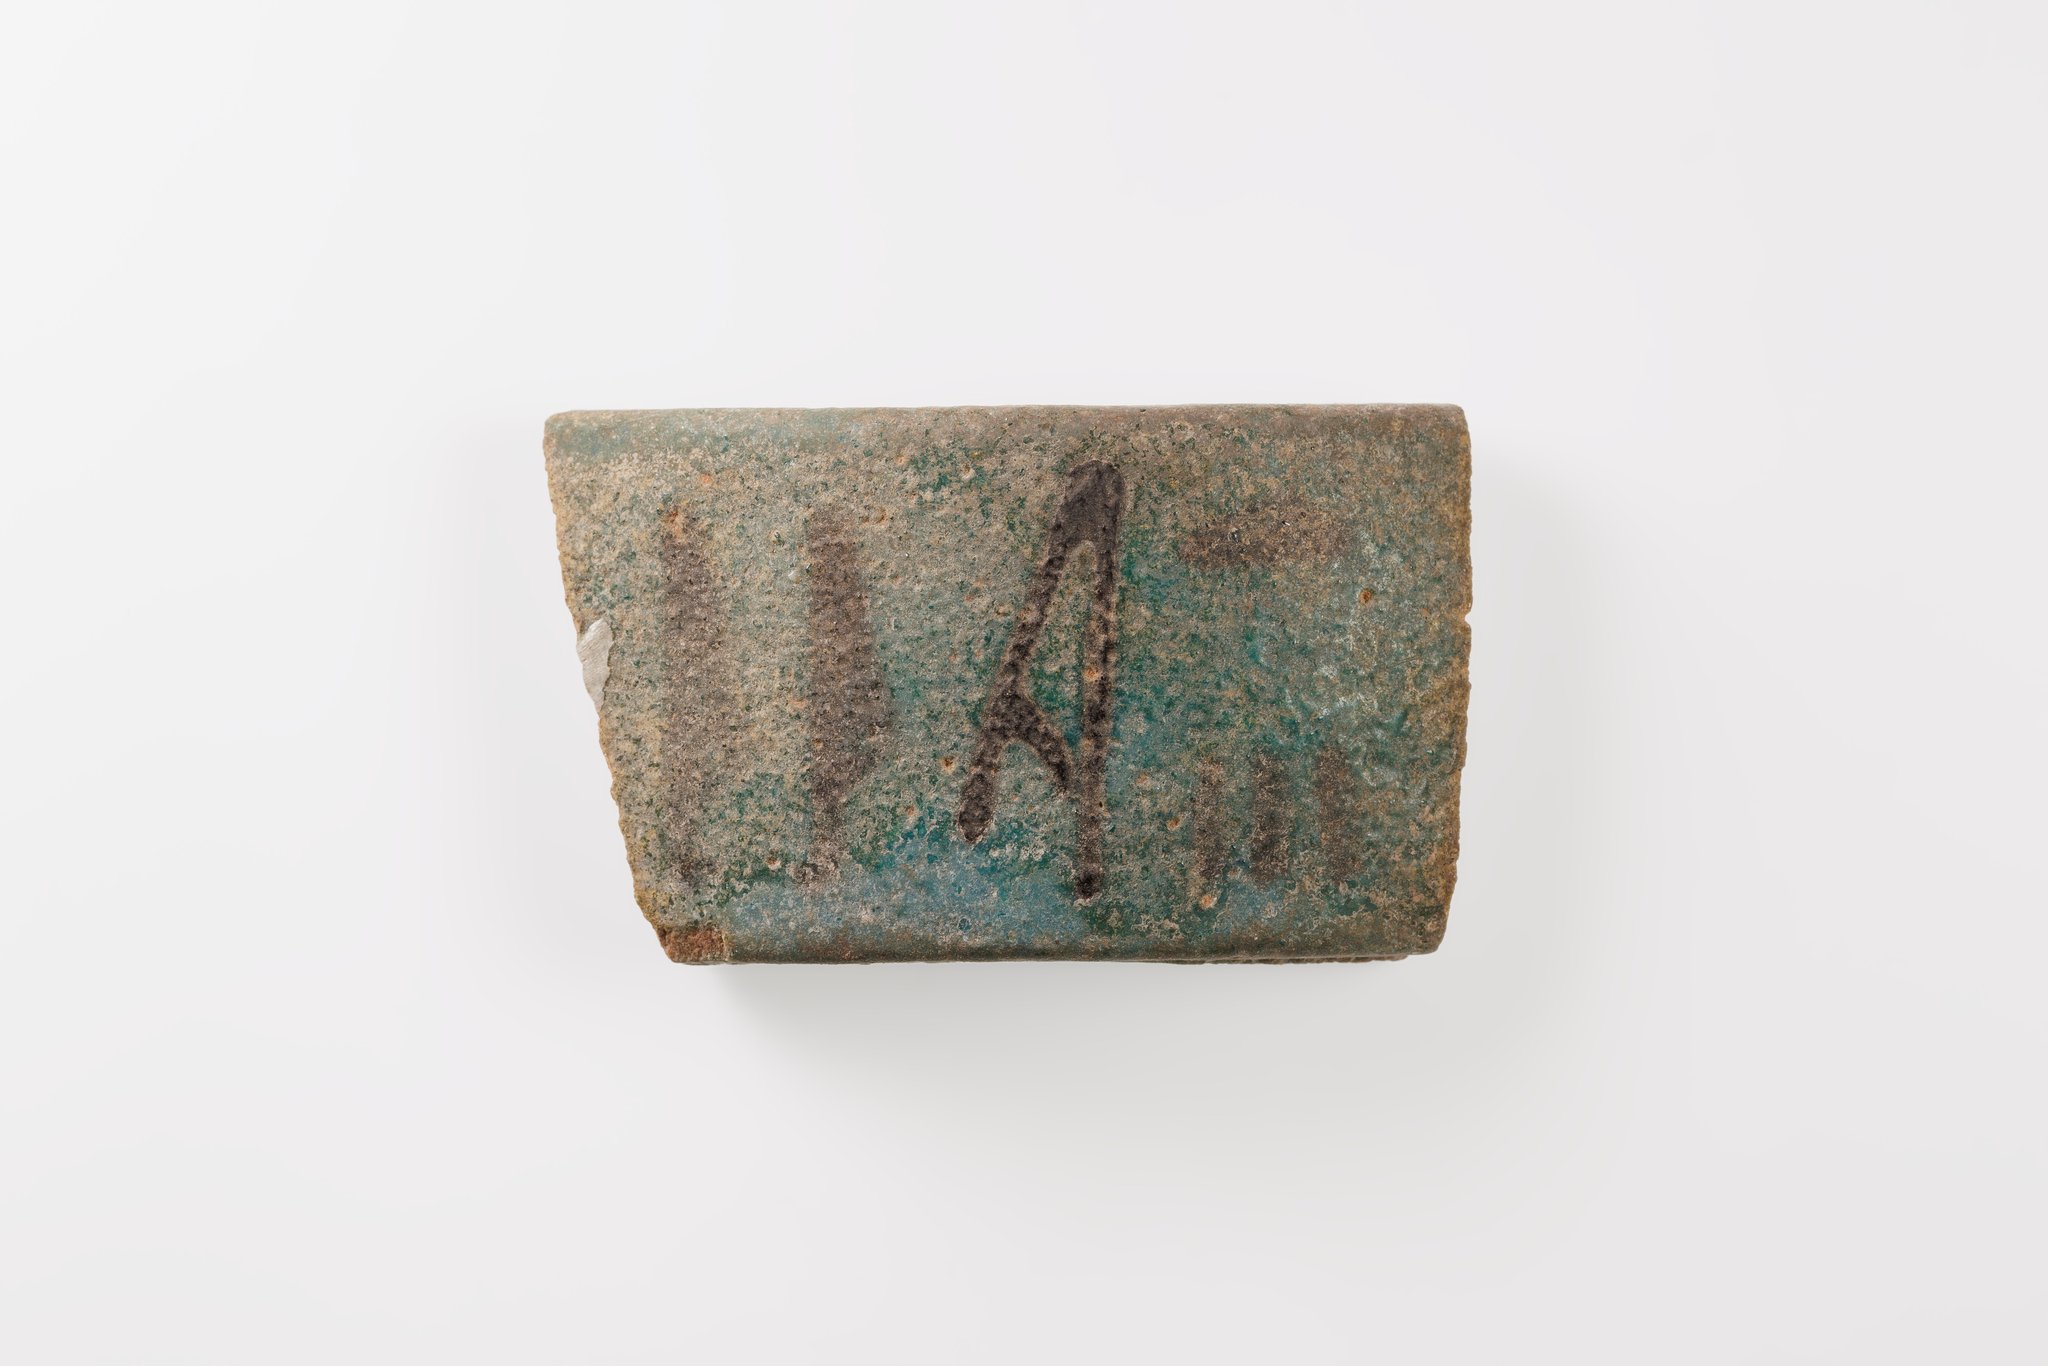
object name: votive bracelet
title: Fragment of a votive bracelet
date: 1295-1070 BCE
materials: faience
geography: egypt